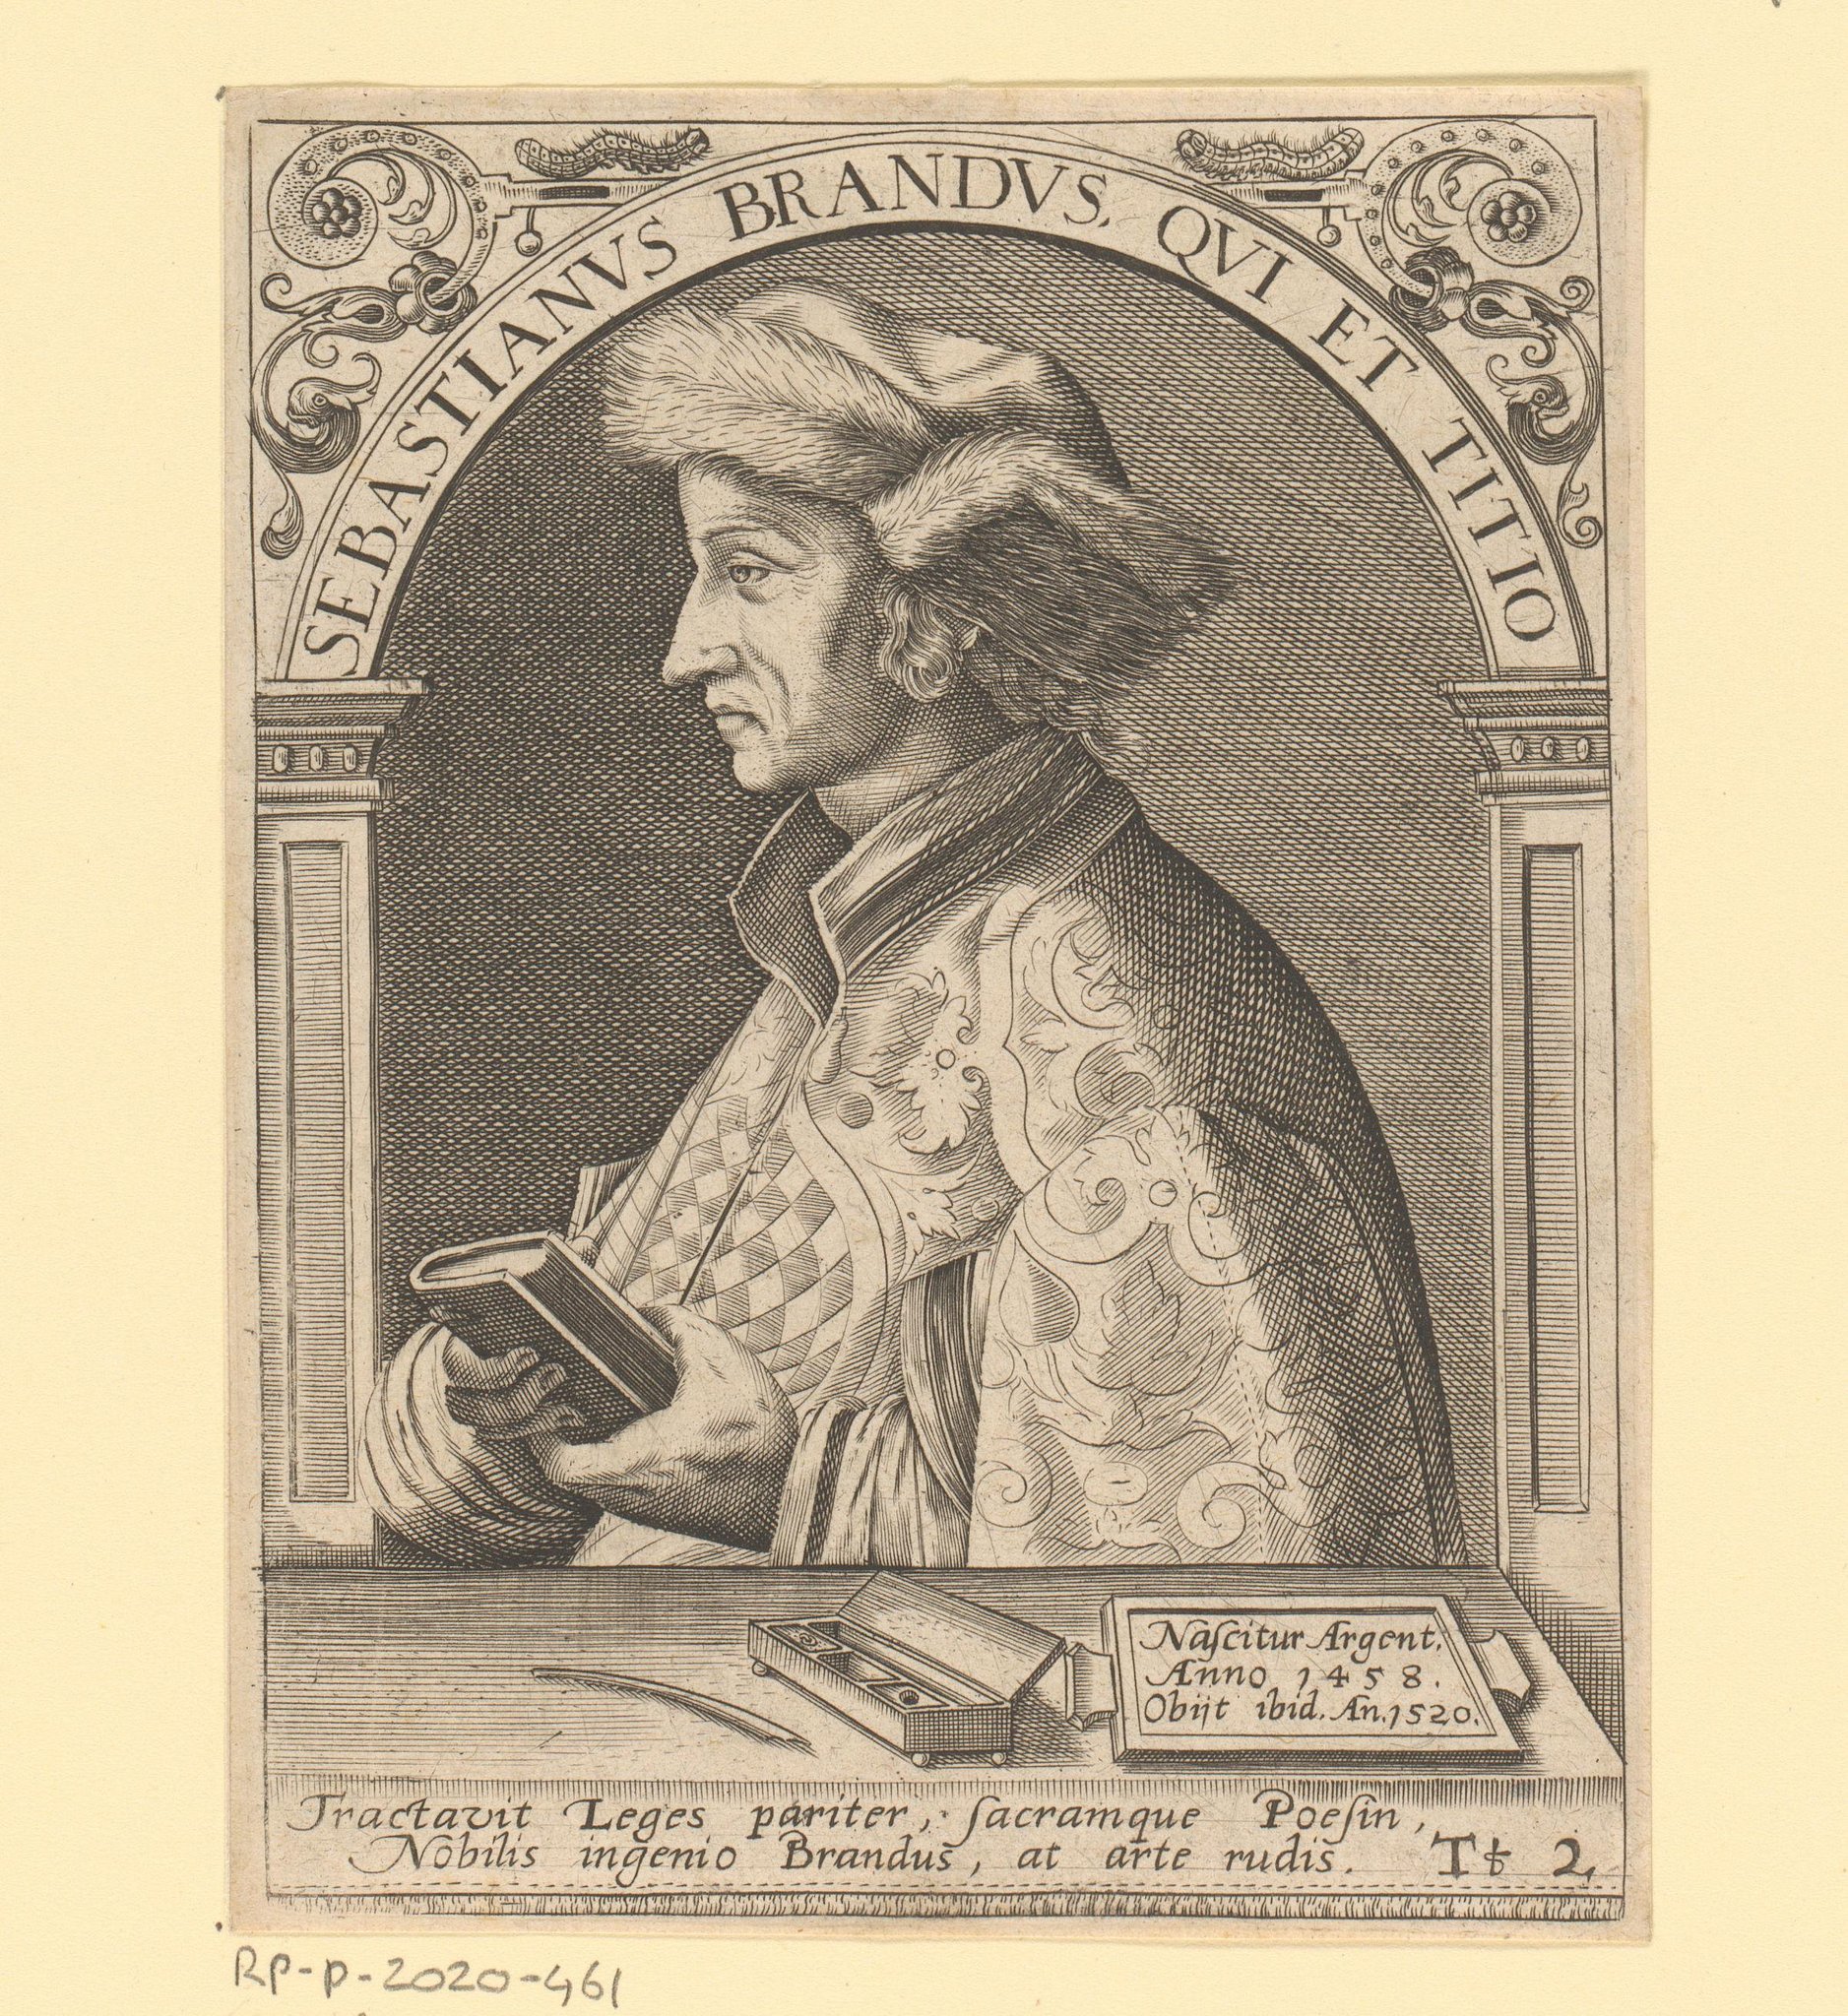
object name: book illustration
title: Portret van Sebastian Brant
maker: jean jacques boissard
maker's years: 1528-1598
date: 1650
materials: paper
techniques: engraving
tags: sebastian brant, historical persons, lawyer, attorney at law, portrait of a writer, writer, poet, author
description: Prent gebruikt in: Boissard, Jean Jacques. Bibliotheca chalcographica. 8 dln. Frankfurt am Main: Johannes Ammon, 1650-1652. Ook gebruikt in latere edities. Eerdere staat van prent verschenen in: Boissard, Jean Jacques. Icones quinquaginta virorum illustrium doctrina & eruditione praestantium ad vivum effictae. 4 dln. Frankfurt am Main: s.n., 1597-1599. Mogelijk ook gebruikt in latere edities.